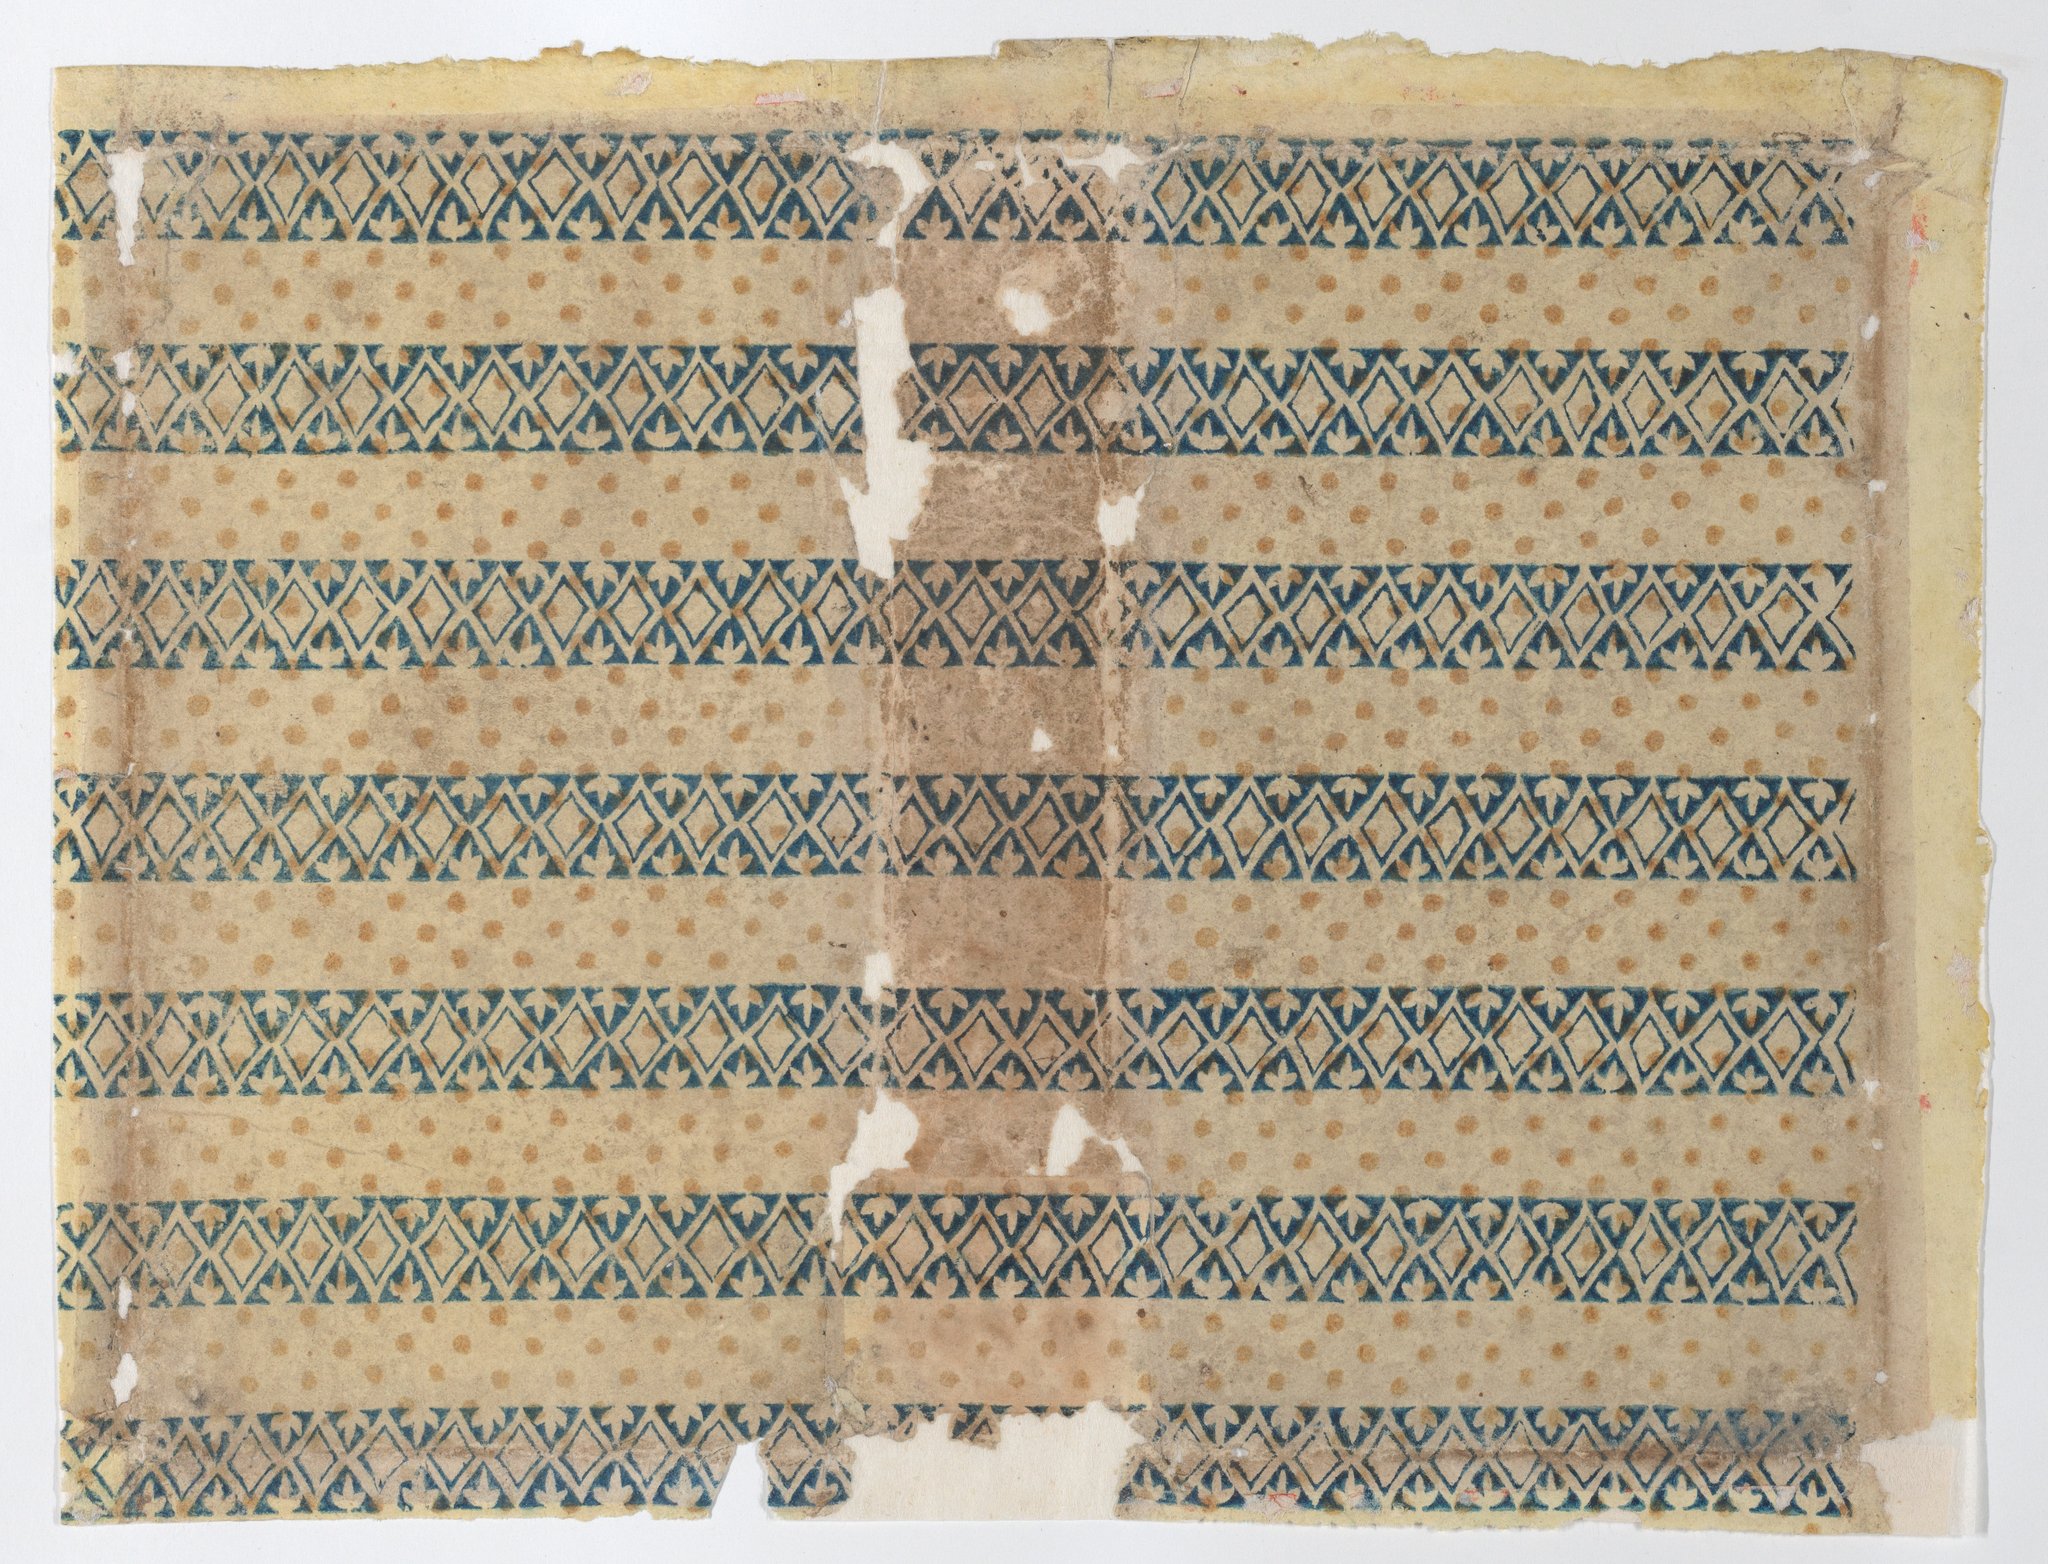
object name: print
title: Book cover with overall dot and diamond pattern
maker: Anonymous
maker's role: artist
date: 1801-1900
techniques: relief print